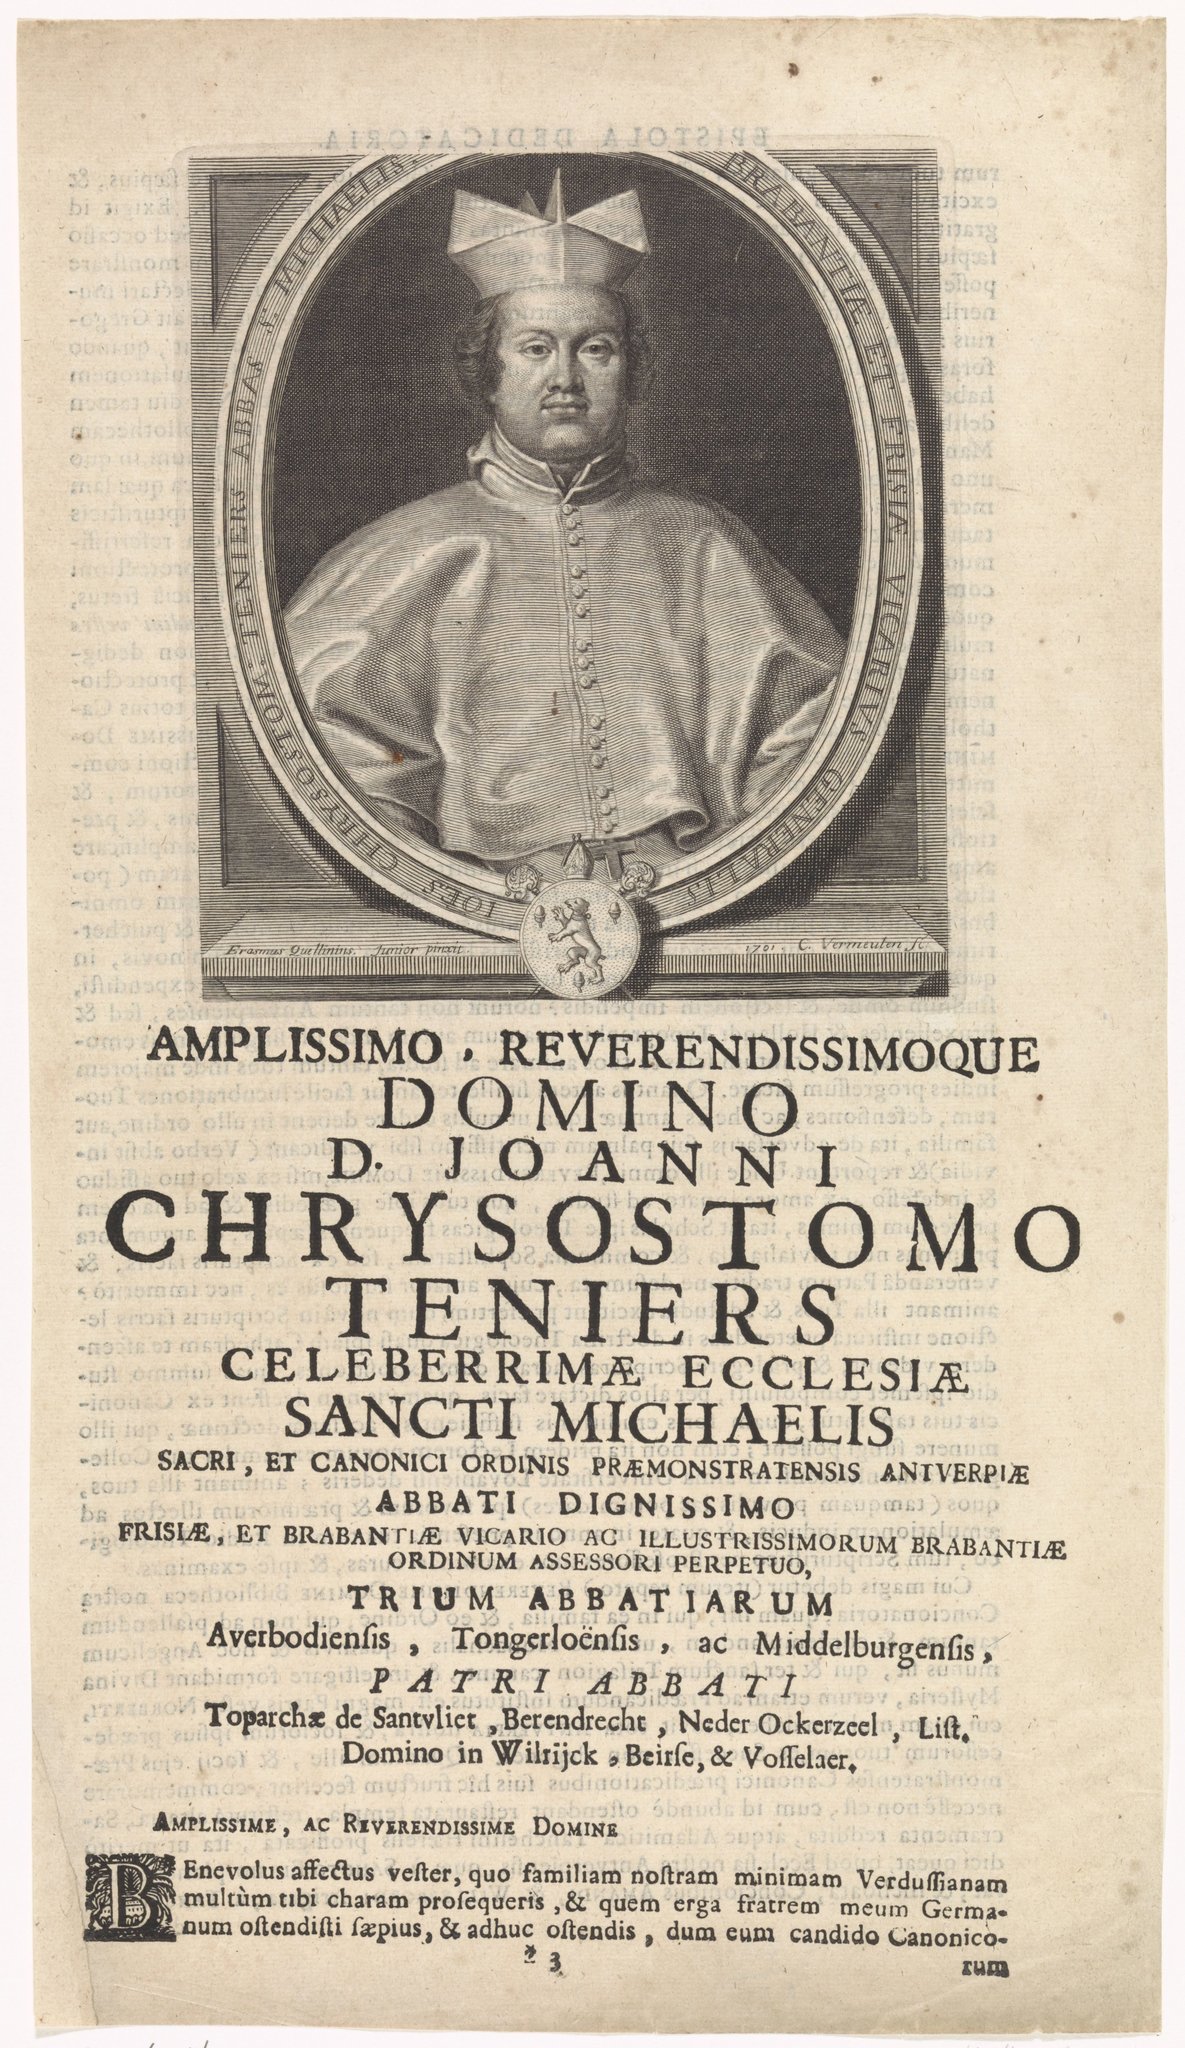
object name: book illustration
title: Portret van Jean-Chrysostome Teniers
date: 1701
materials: paper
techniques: engraving, letterpress printing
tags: clergyman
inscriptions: collector's mark: Lugt 2228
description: Prent gebruikt als boekillustratie in: Mansi, Guiseppe. Locupletissima bibliotheca moralis praedicabilis, hoc est, Discursus varii exquisiti (...). Antwerpen: Johannes Baptist Verdussen, 1701